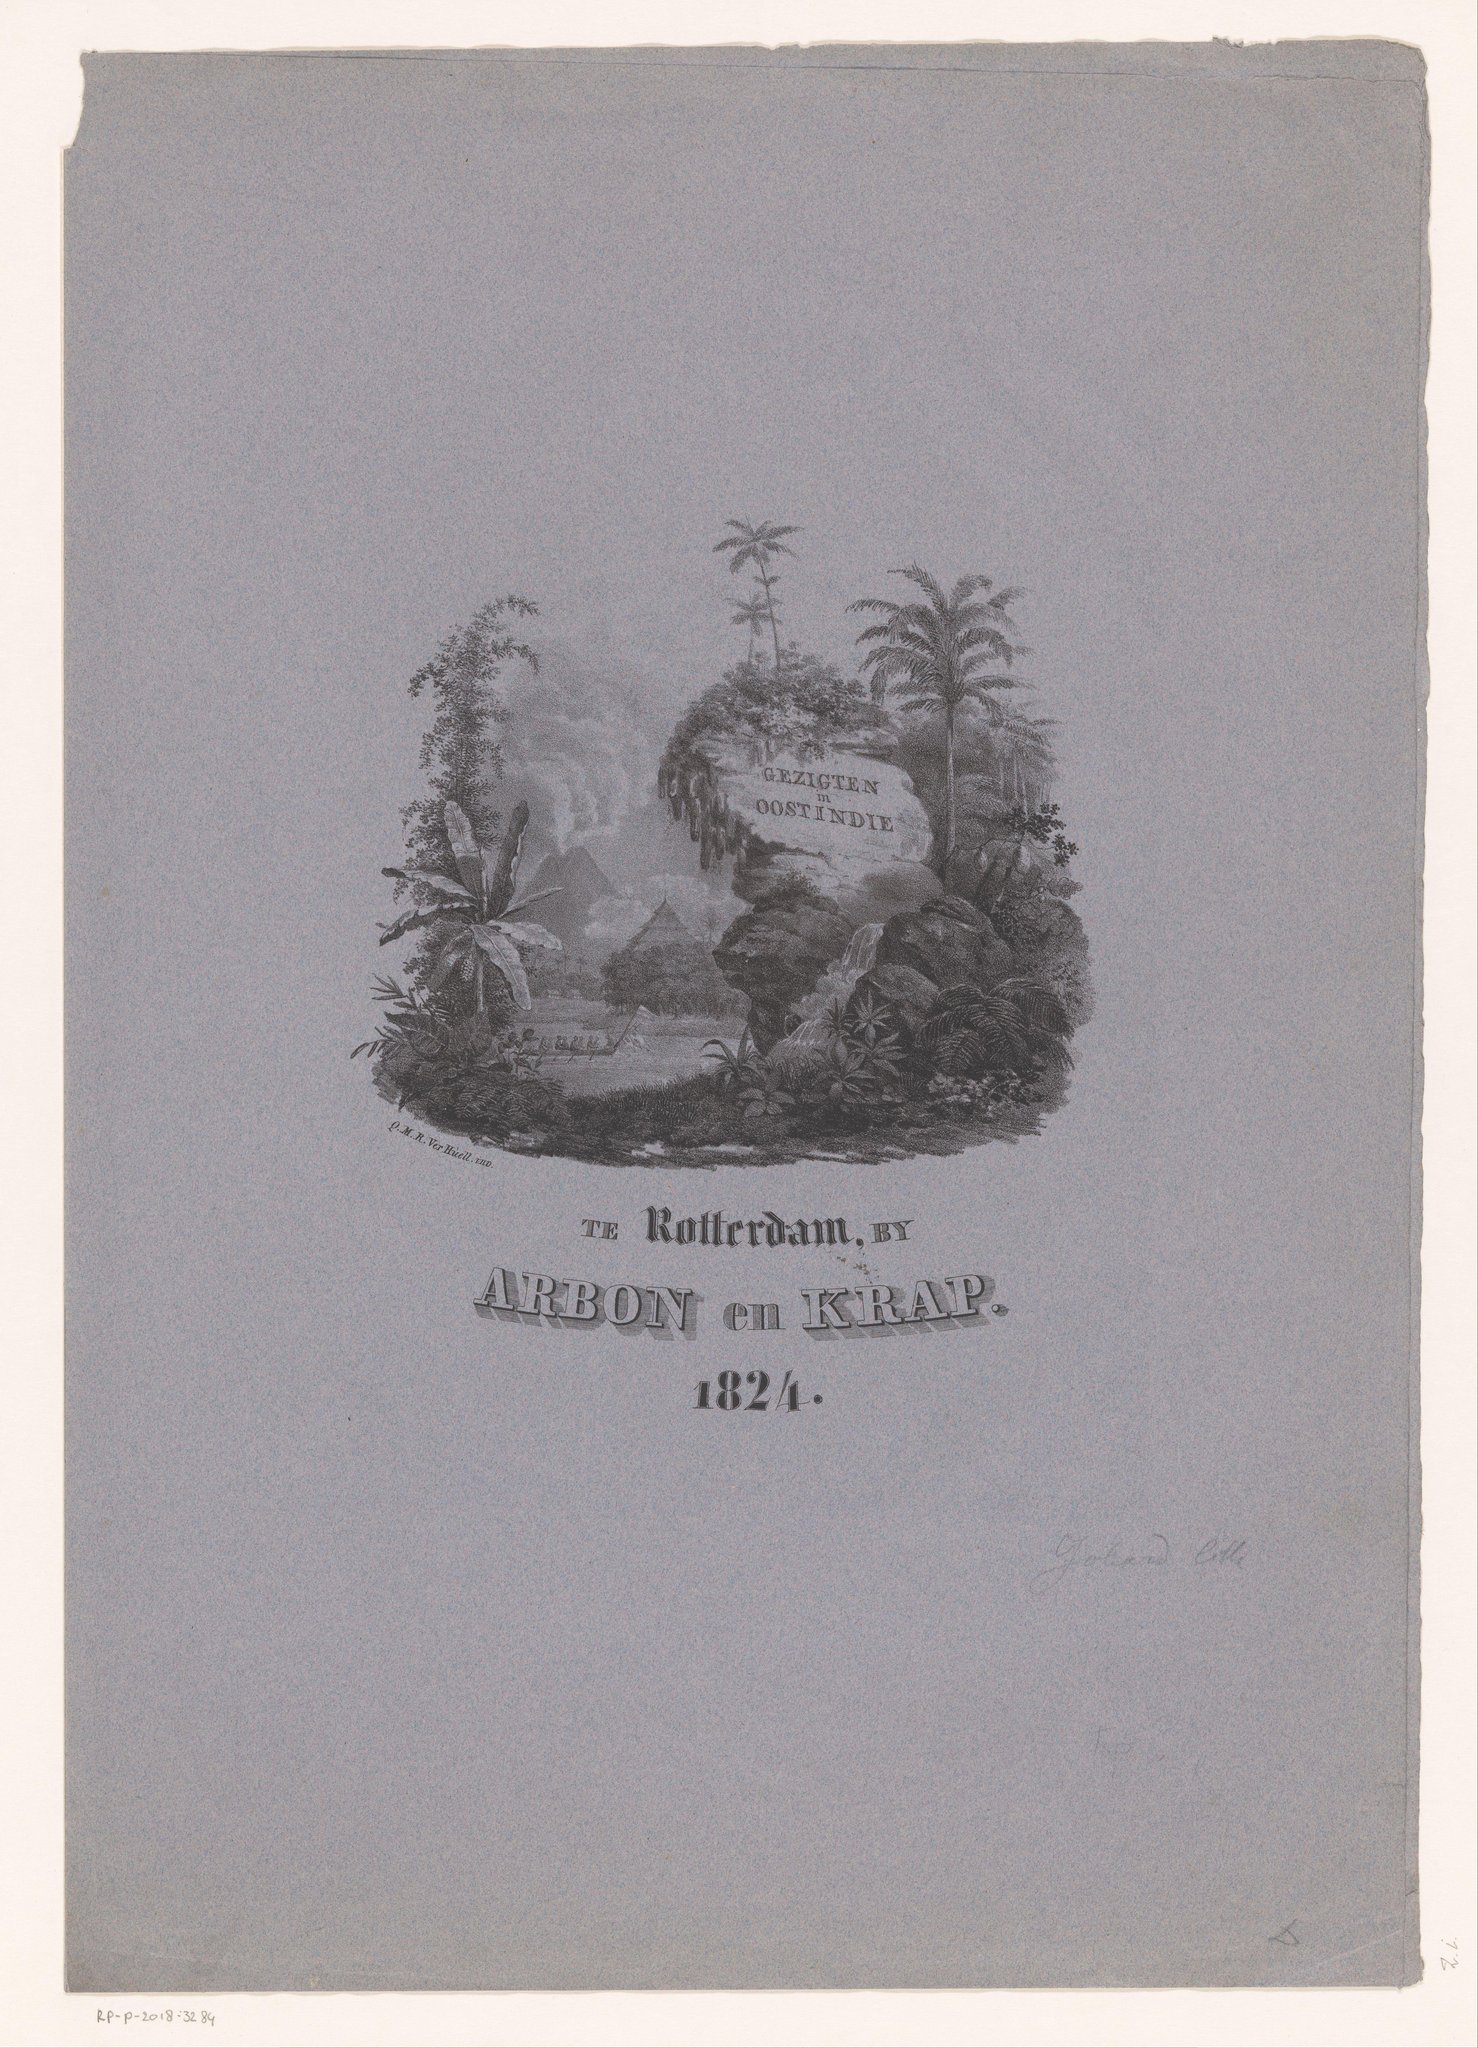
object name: wrapper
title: Gezigten in Oostindie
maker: quirijn maurits rudolf ver huell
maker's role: draughtsman, print maker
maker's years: 1787-1860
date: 1824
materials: paper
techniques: lithograph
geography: rotterdam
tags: landscapes in tropical and sub-tropical regions, eastern asia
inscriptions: collector's mark: Lugt 2228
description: Omslag van: Ver Huell, Quirijn Maurits Rudolf. Gezigten in Oost-Indië, naar de natuur getekend, met een beschrijving. Rotterdam: Arbon en Krap, 1824.